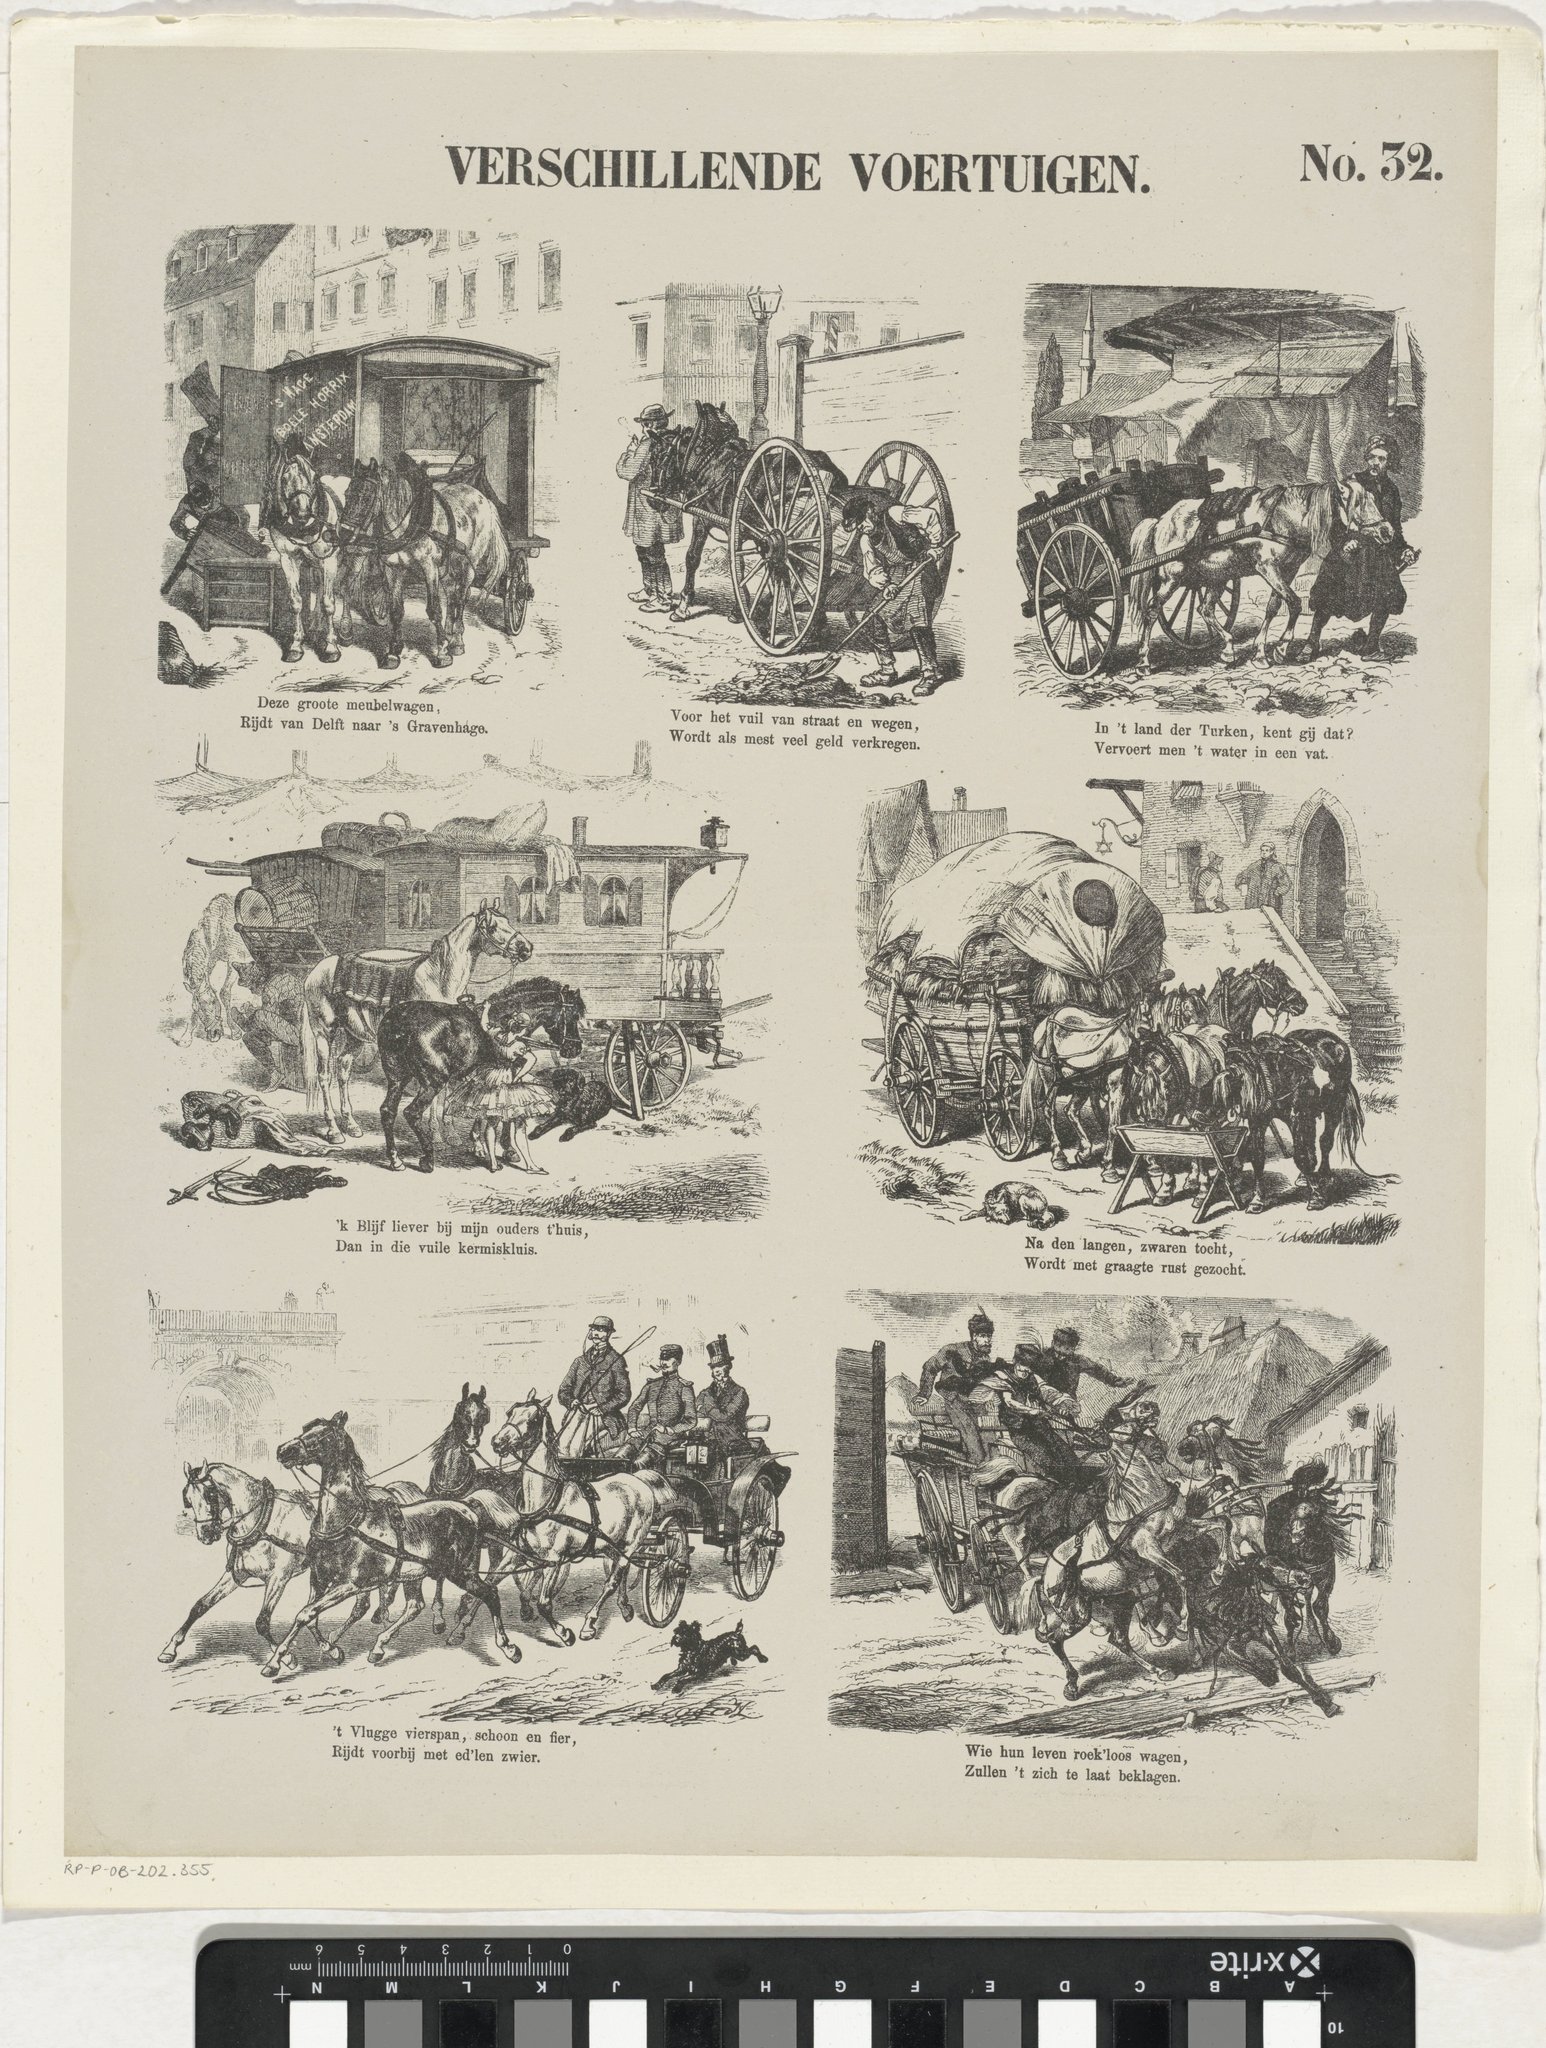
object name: popular print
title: Verschillende voertuigen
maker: Anonymous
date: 1874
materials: paper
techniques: letterpress printing, lithograph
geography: amsterdam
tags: traffic and transport, caravan (trailer), four-wheeled, animal-drawn vehicle, e.g.: cab, carriage, coach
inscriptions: collector's mark: Lugt 2760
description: Blad met 7 voorstellingen van voertuigen, waaronder een meubelwagen, een woonwagen en een vierspan. Onder elke afbeelding een tweeregelig vers. Genummerd rechtsboven: No. 32.